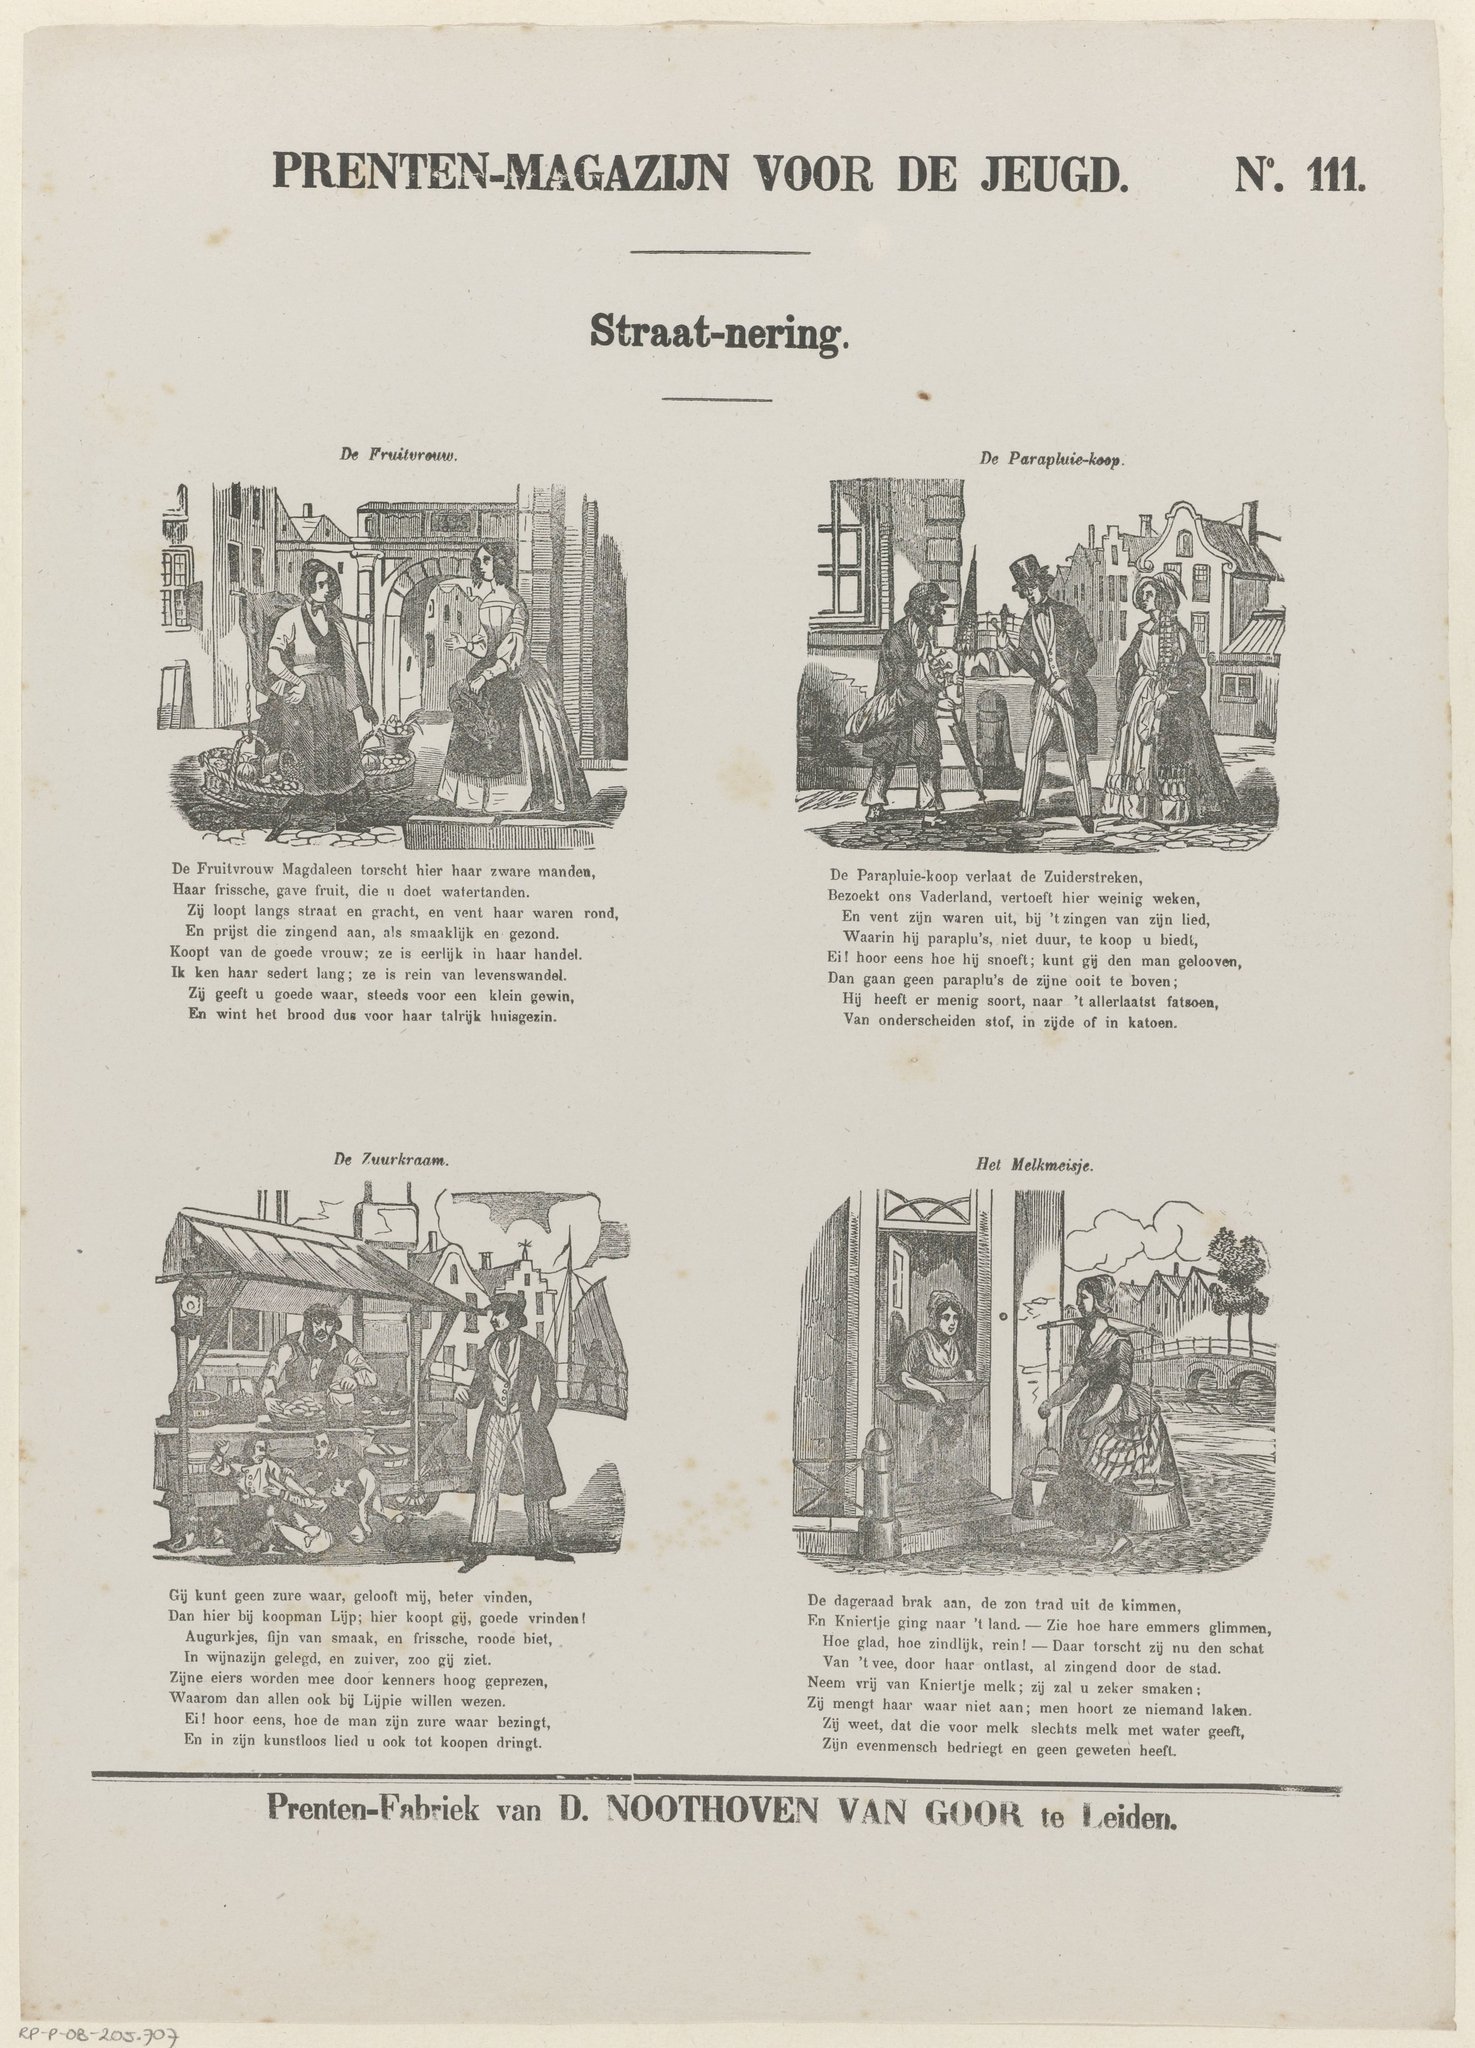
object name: print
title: Prenten-magazijn voor de jeugd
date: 1850-1881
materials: paper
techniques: letterpress printing, engraving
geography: netherlands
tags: street-trader, milkmaid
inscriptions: collector's mark: Lugt 2760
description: Blad met 4 voorstellingen van straatverkopers: een fruitverkoopster, een parapluverkoper, een verkoper van zure producten en een melkmeid. Boven elke afbeelding een titel, onder elke afbeelding een achtregelig vers. Genummerd rechtsboven: No. 111.